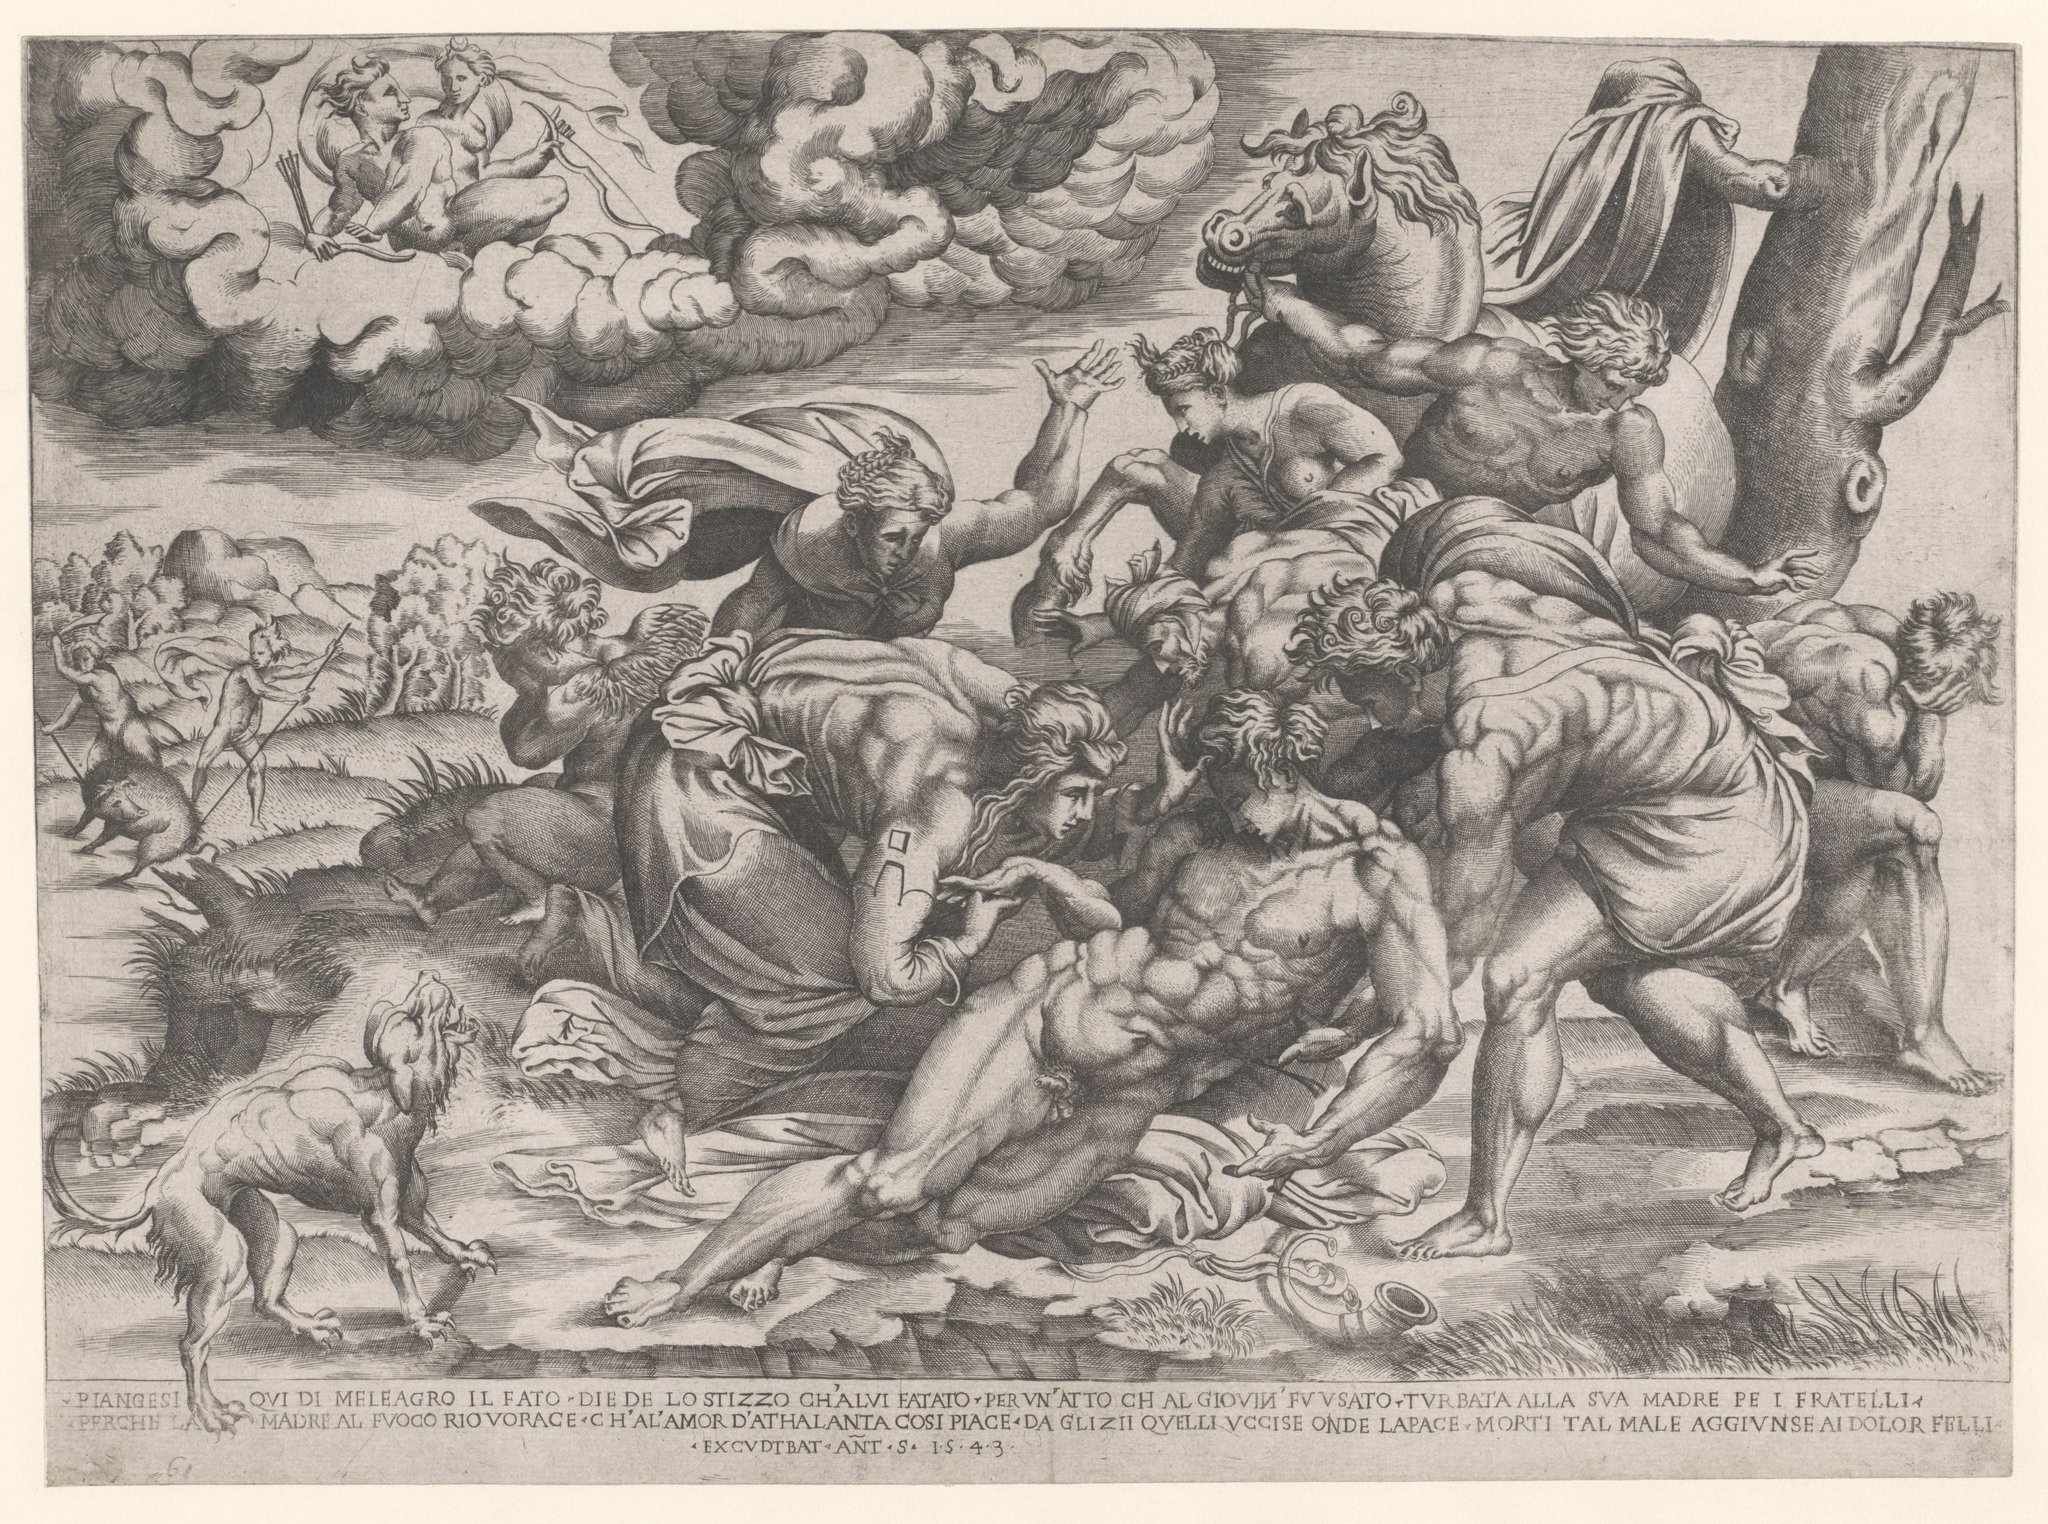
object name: print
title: Dood van Meleager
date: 1543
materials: paper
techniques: engraving, etching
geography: italy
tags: death of meleager: althaea throws the unburnt brand into the fire, thus causing meleager's death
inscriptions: collector's mark: Lugt 2228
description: Meleager ligt naakt op de voorgrond. Hij wordt door verschillende treurende figuren omdersteund. Linksvoor een hond. Op de achtergrond twee mannen die jagen op een wild zwijn. Tekst in het het Italiaans in ondermarge.